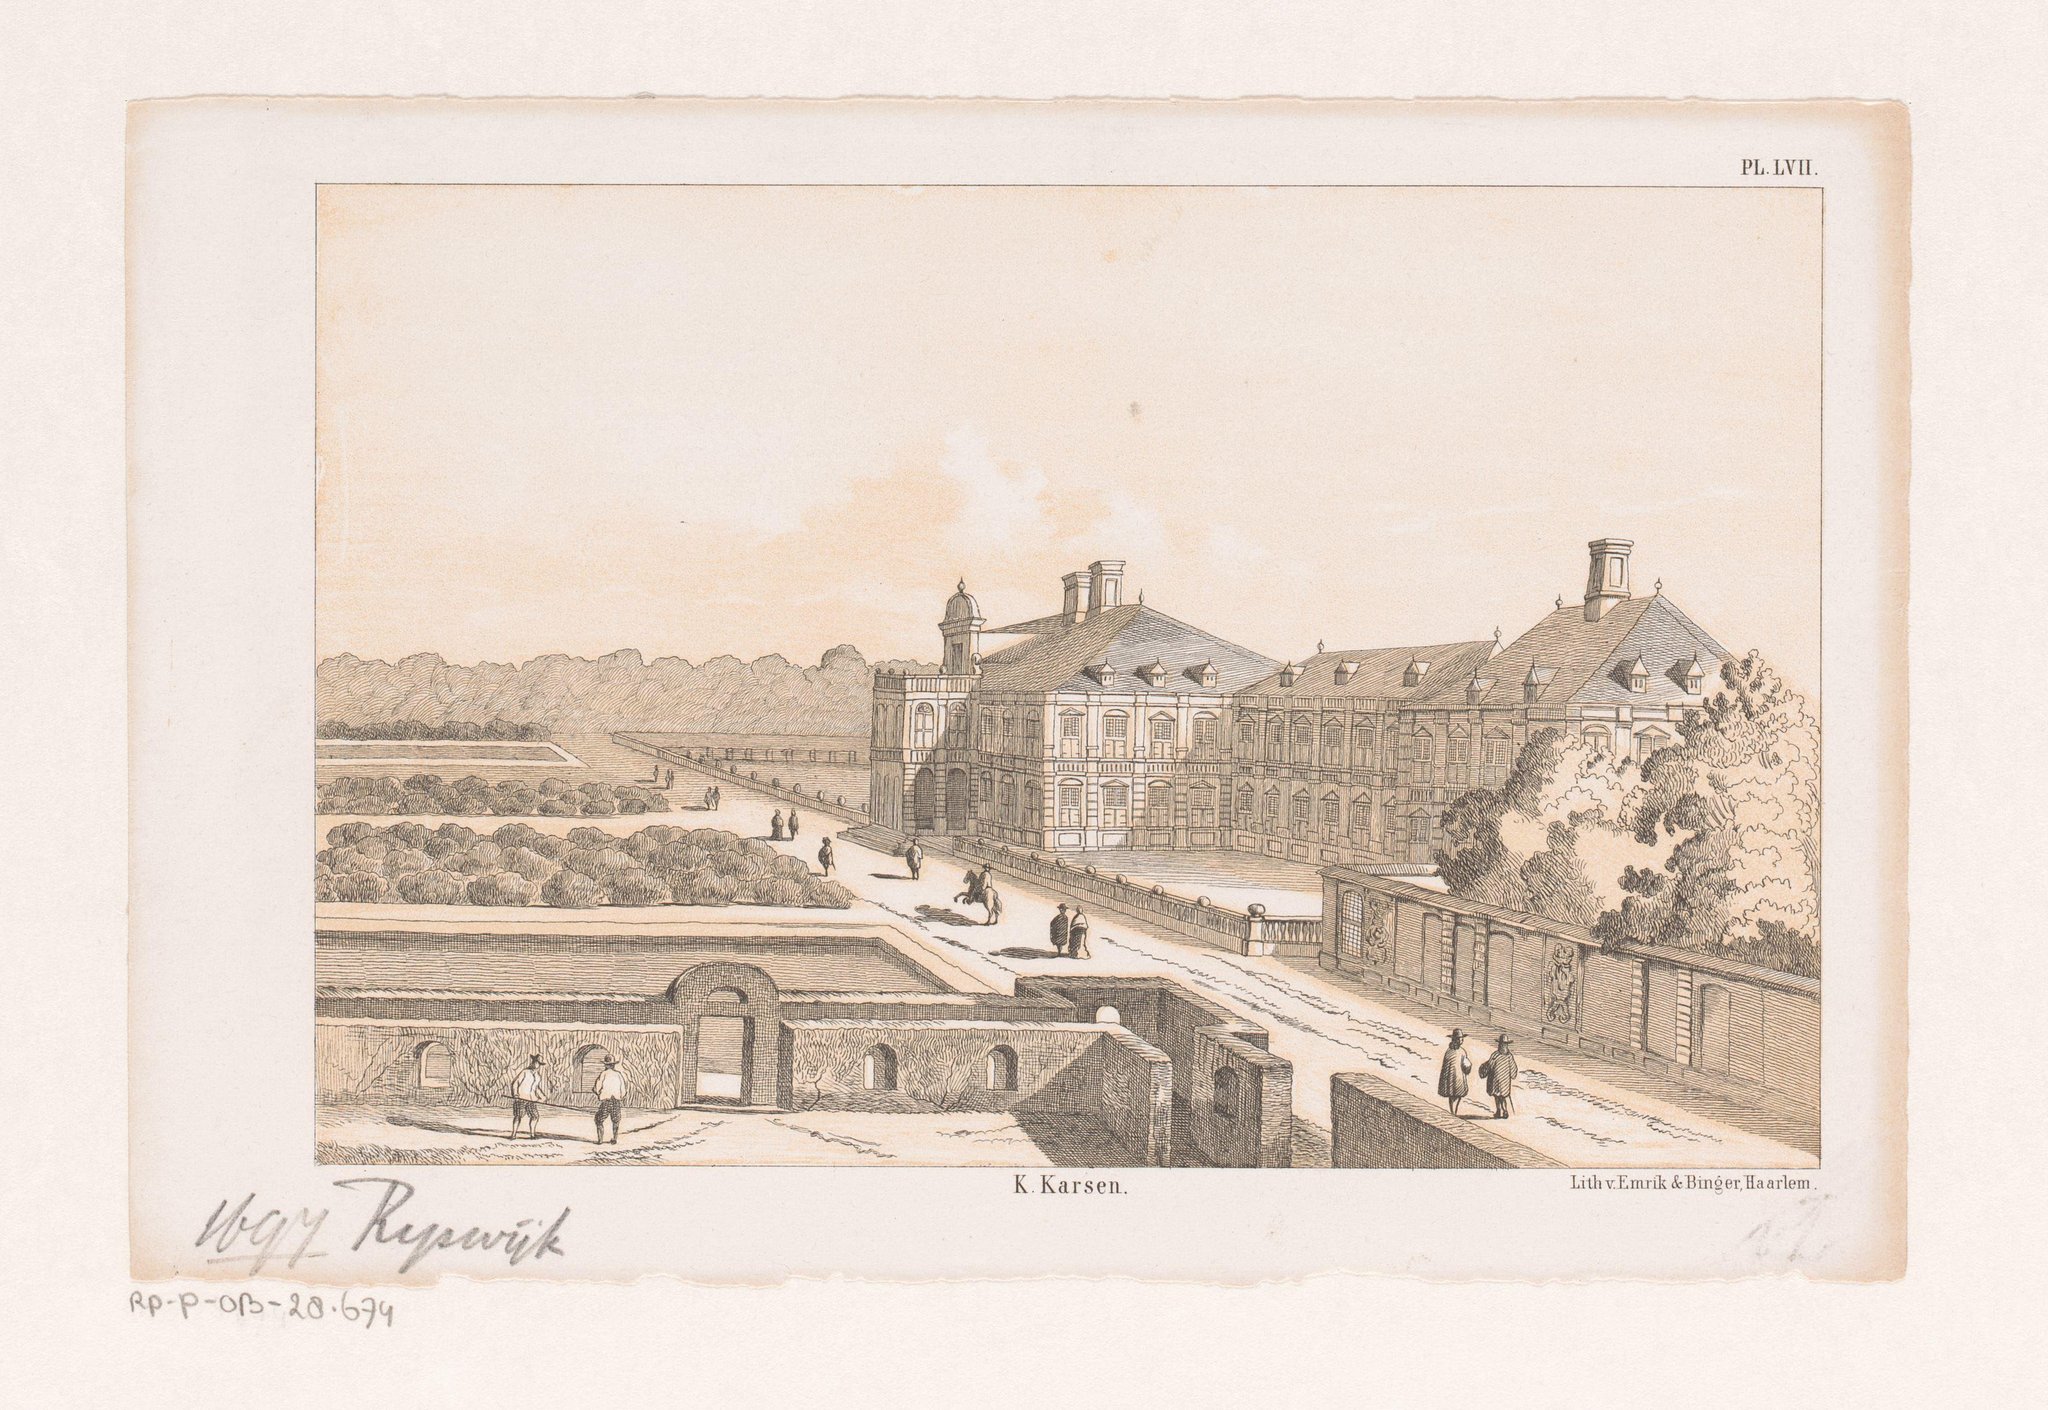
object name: print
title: Huis ter Nieuburch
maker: kasparus karsen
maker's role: draughtsman, painter, print maker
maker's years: 1810-1896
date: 1820-1896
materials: paper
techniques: tone lithography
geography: haarlem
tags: garden, palace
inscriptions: collector's mark: Lugt 2228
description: Links van het paleis de tuinen. Op de weg tussen de tuinen en het hoofdgebouw lopen figuren. Genummerd rechtsboven: Pl. LVII.